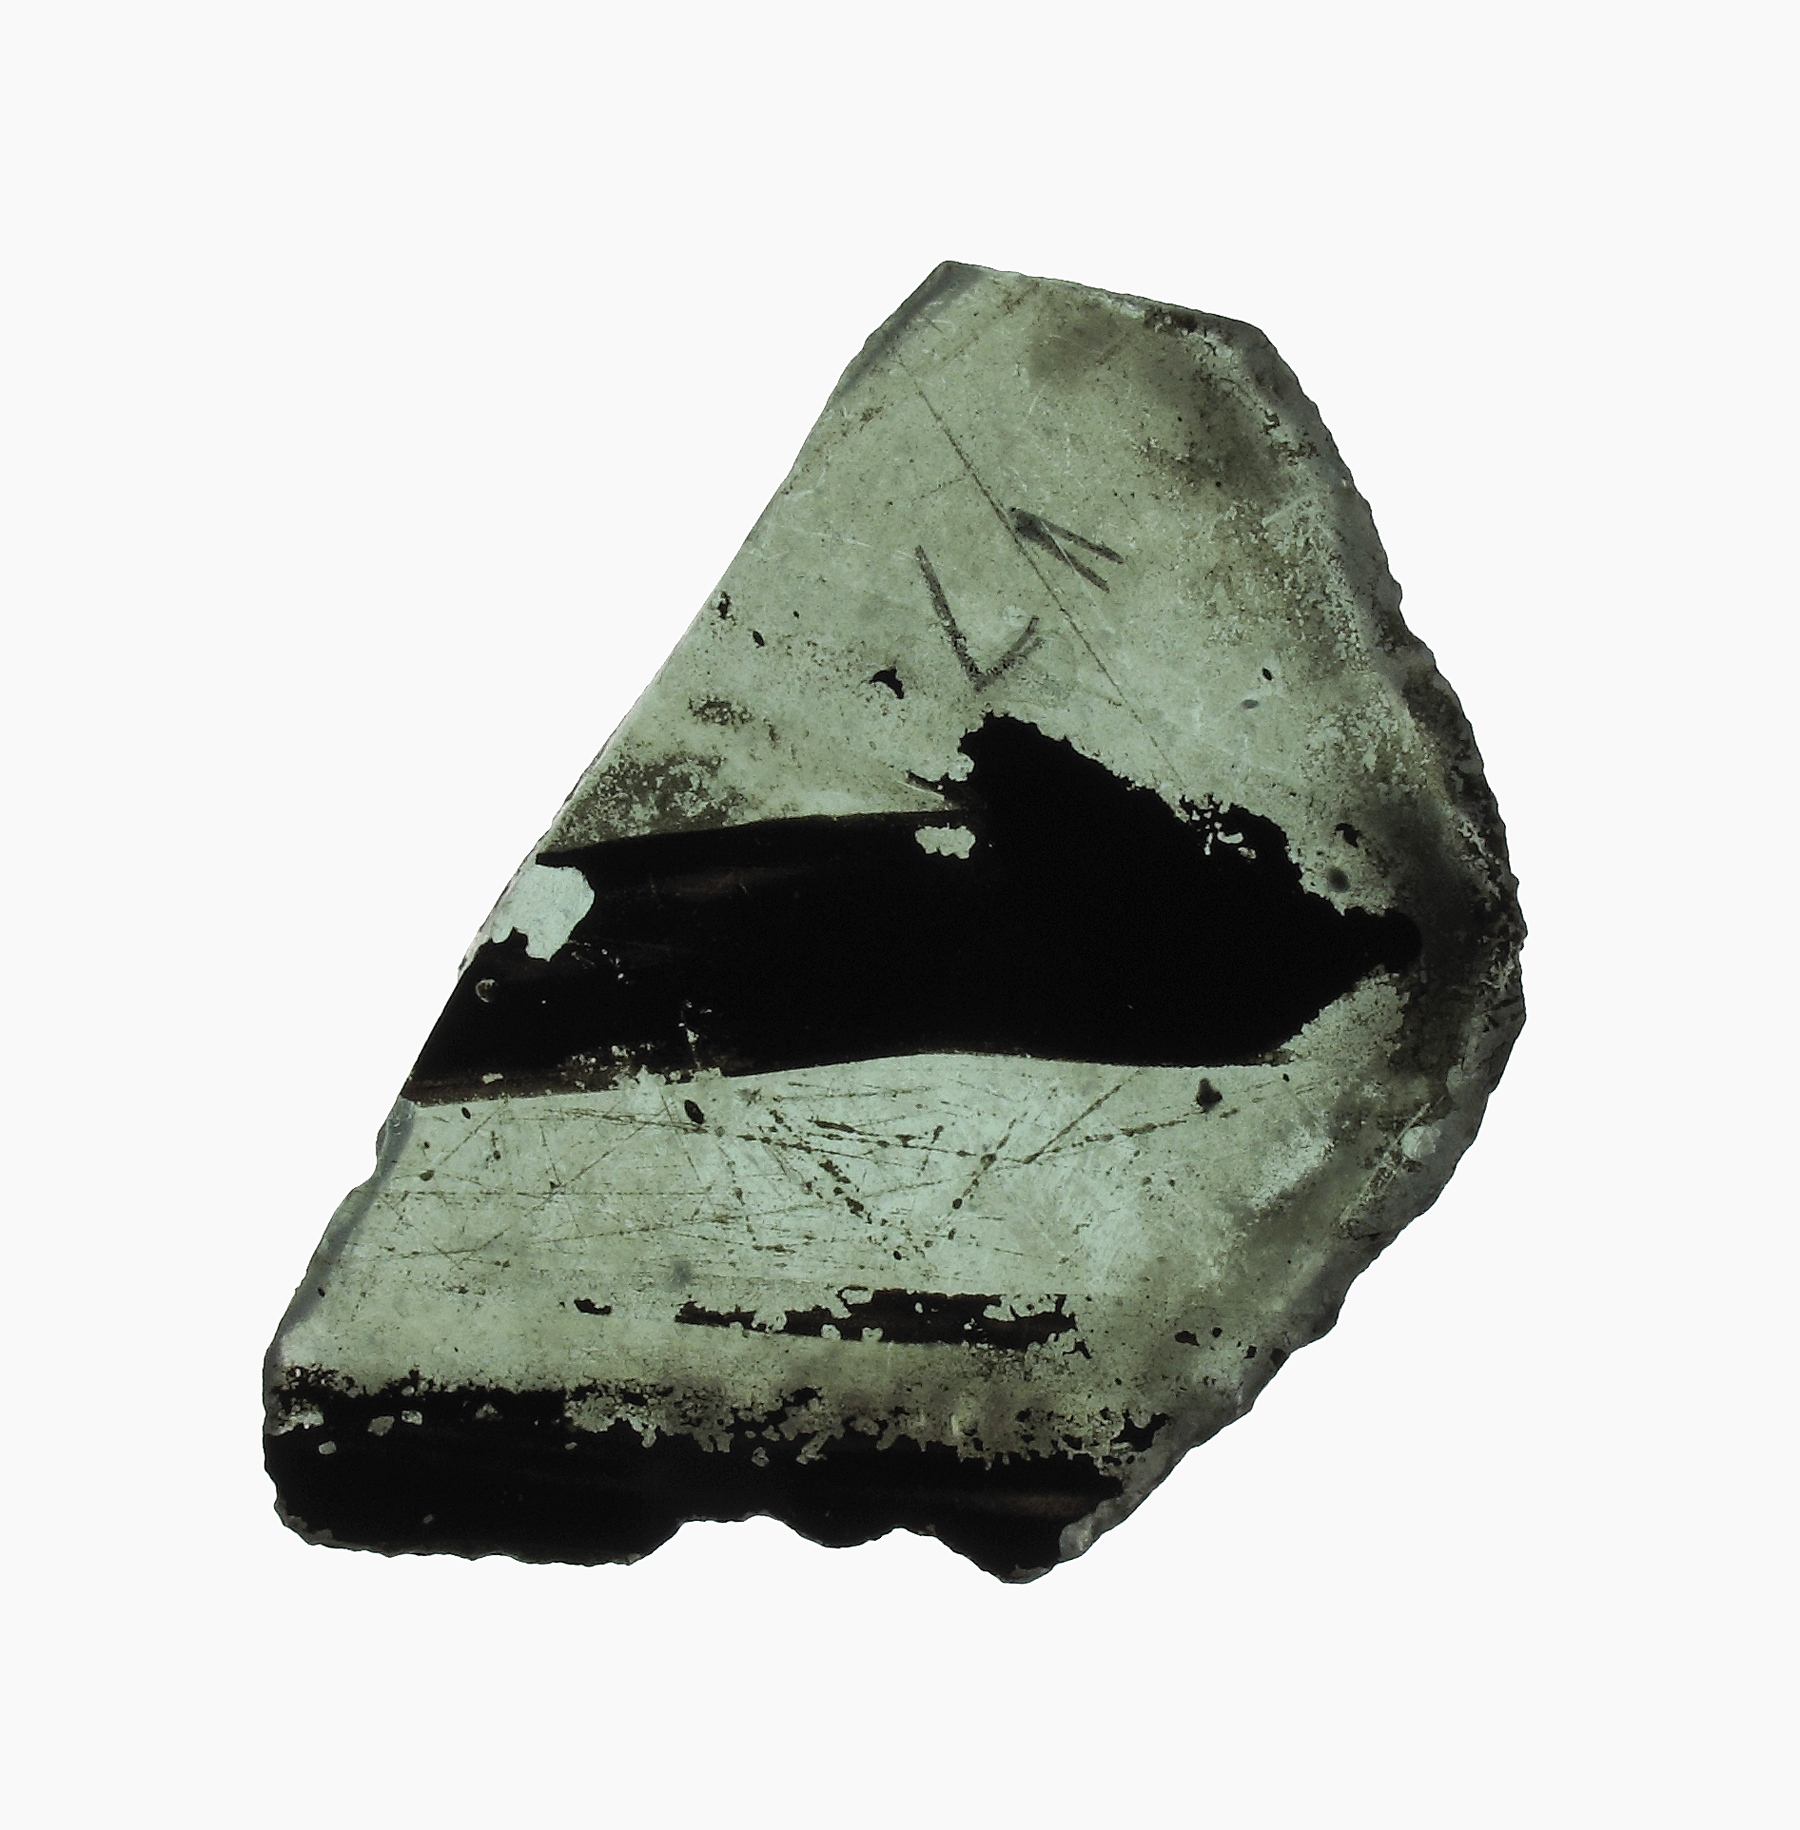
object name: fragment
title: Glass Fragment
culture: french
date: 1201-1300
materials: glass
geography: france